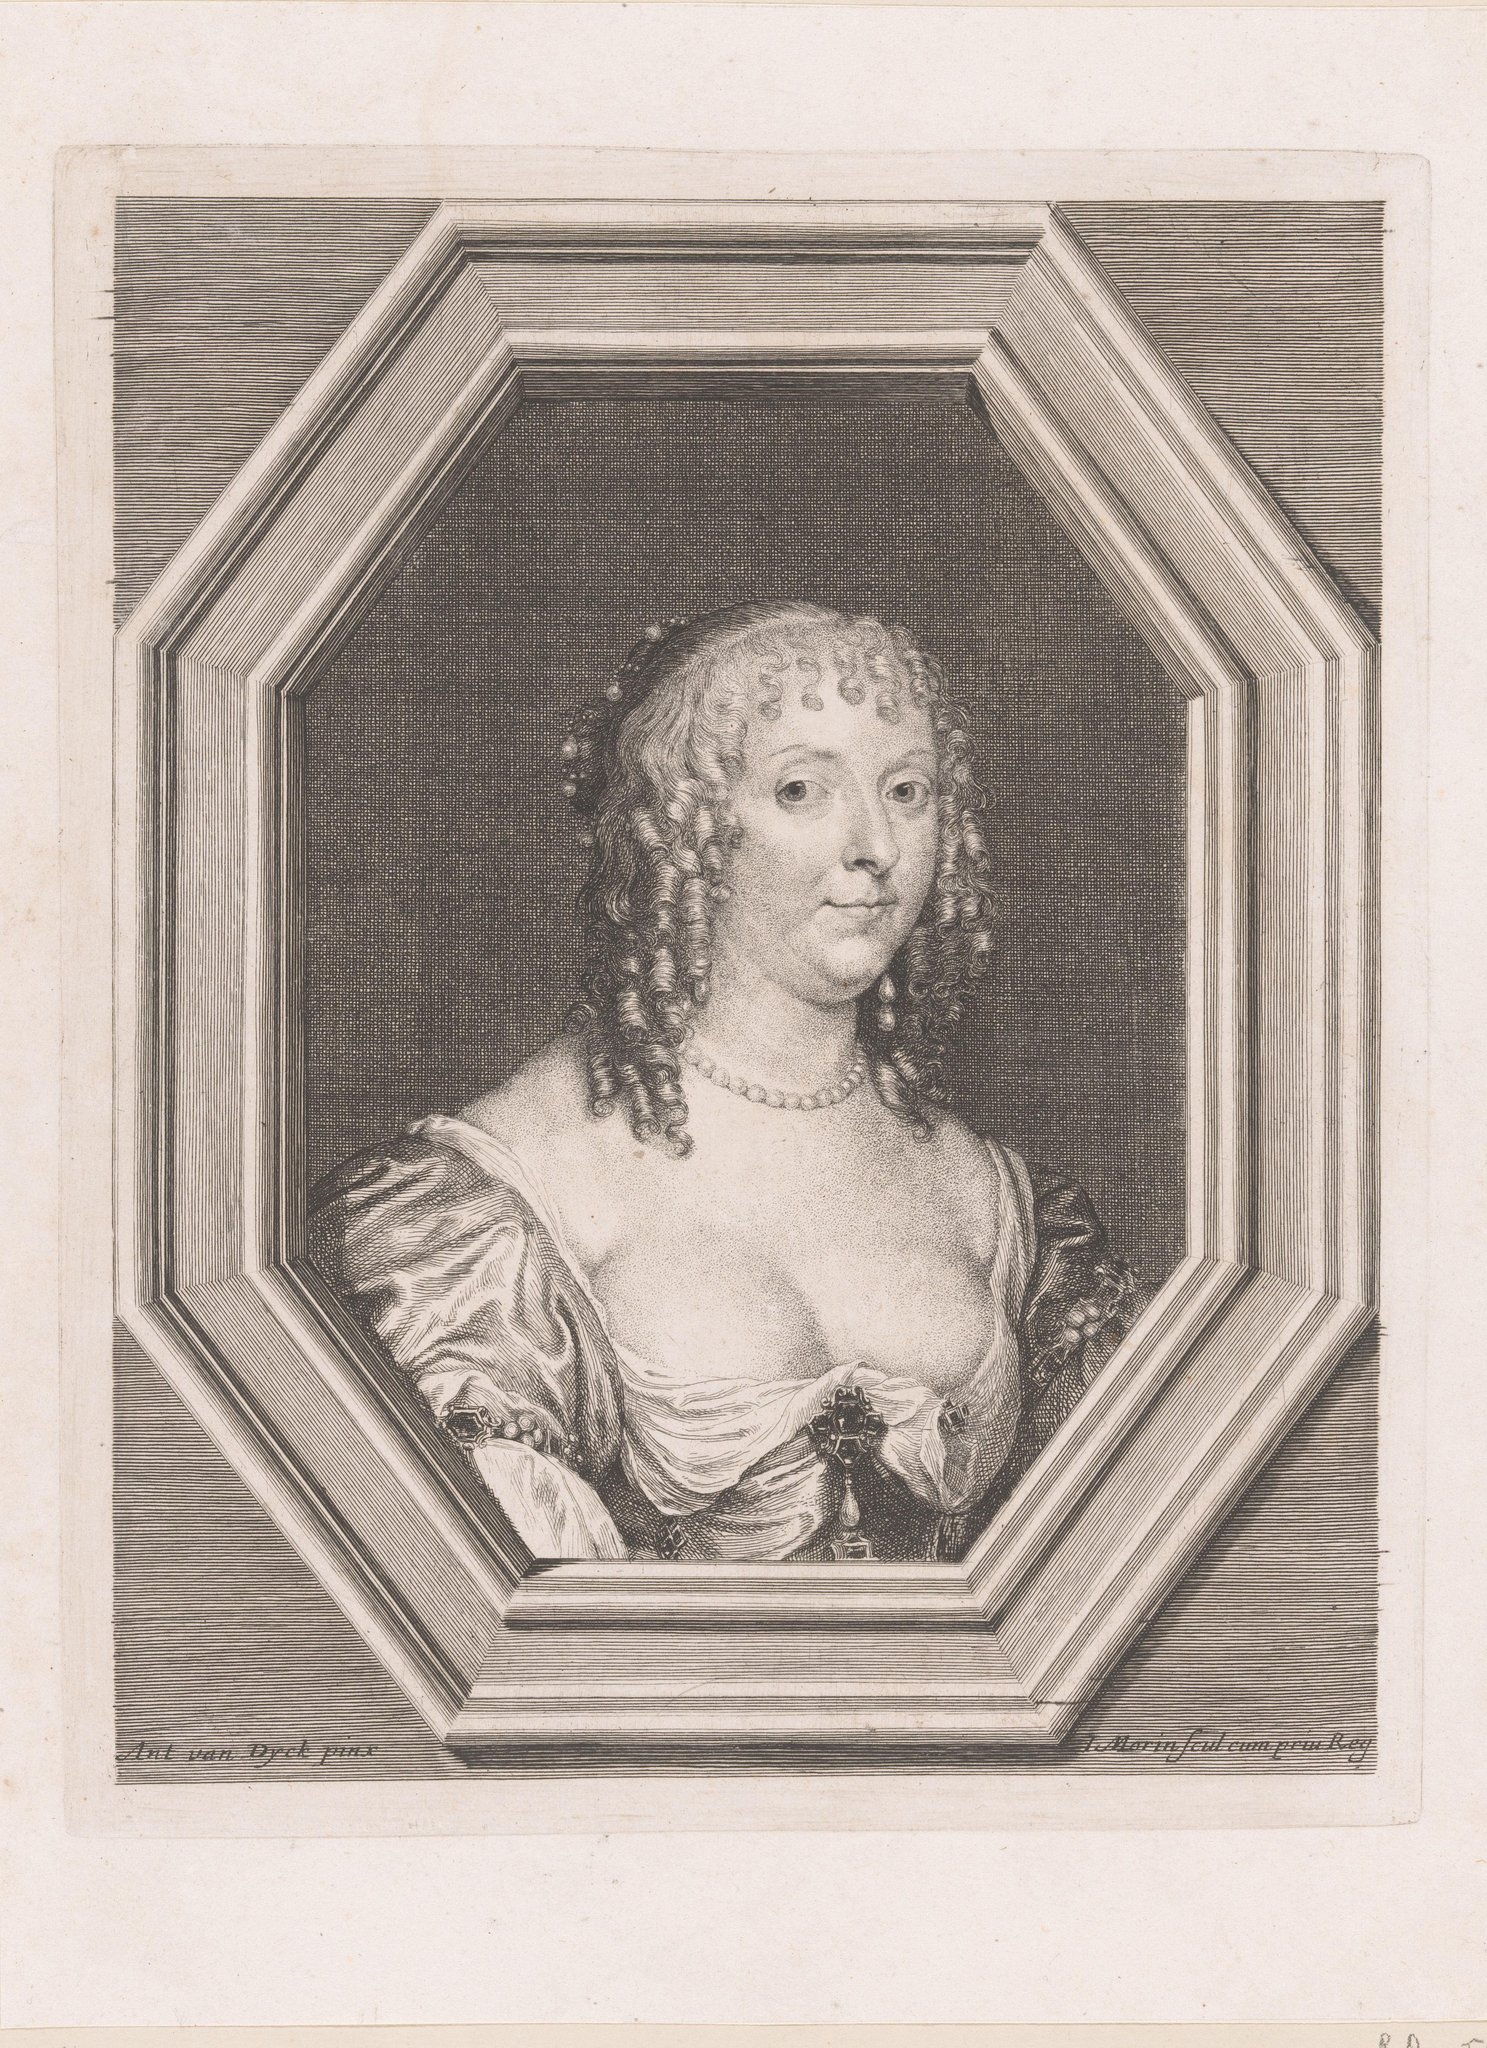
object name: print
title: Portret van Honorée de Glimes-Grimberghe, Gravin van Bossut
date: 1610-1650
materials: paper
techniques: engraving, etching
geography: france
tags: historical persons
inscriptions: collector's mark: Lugt 2228